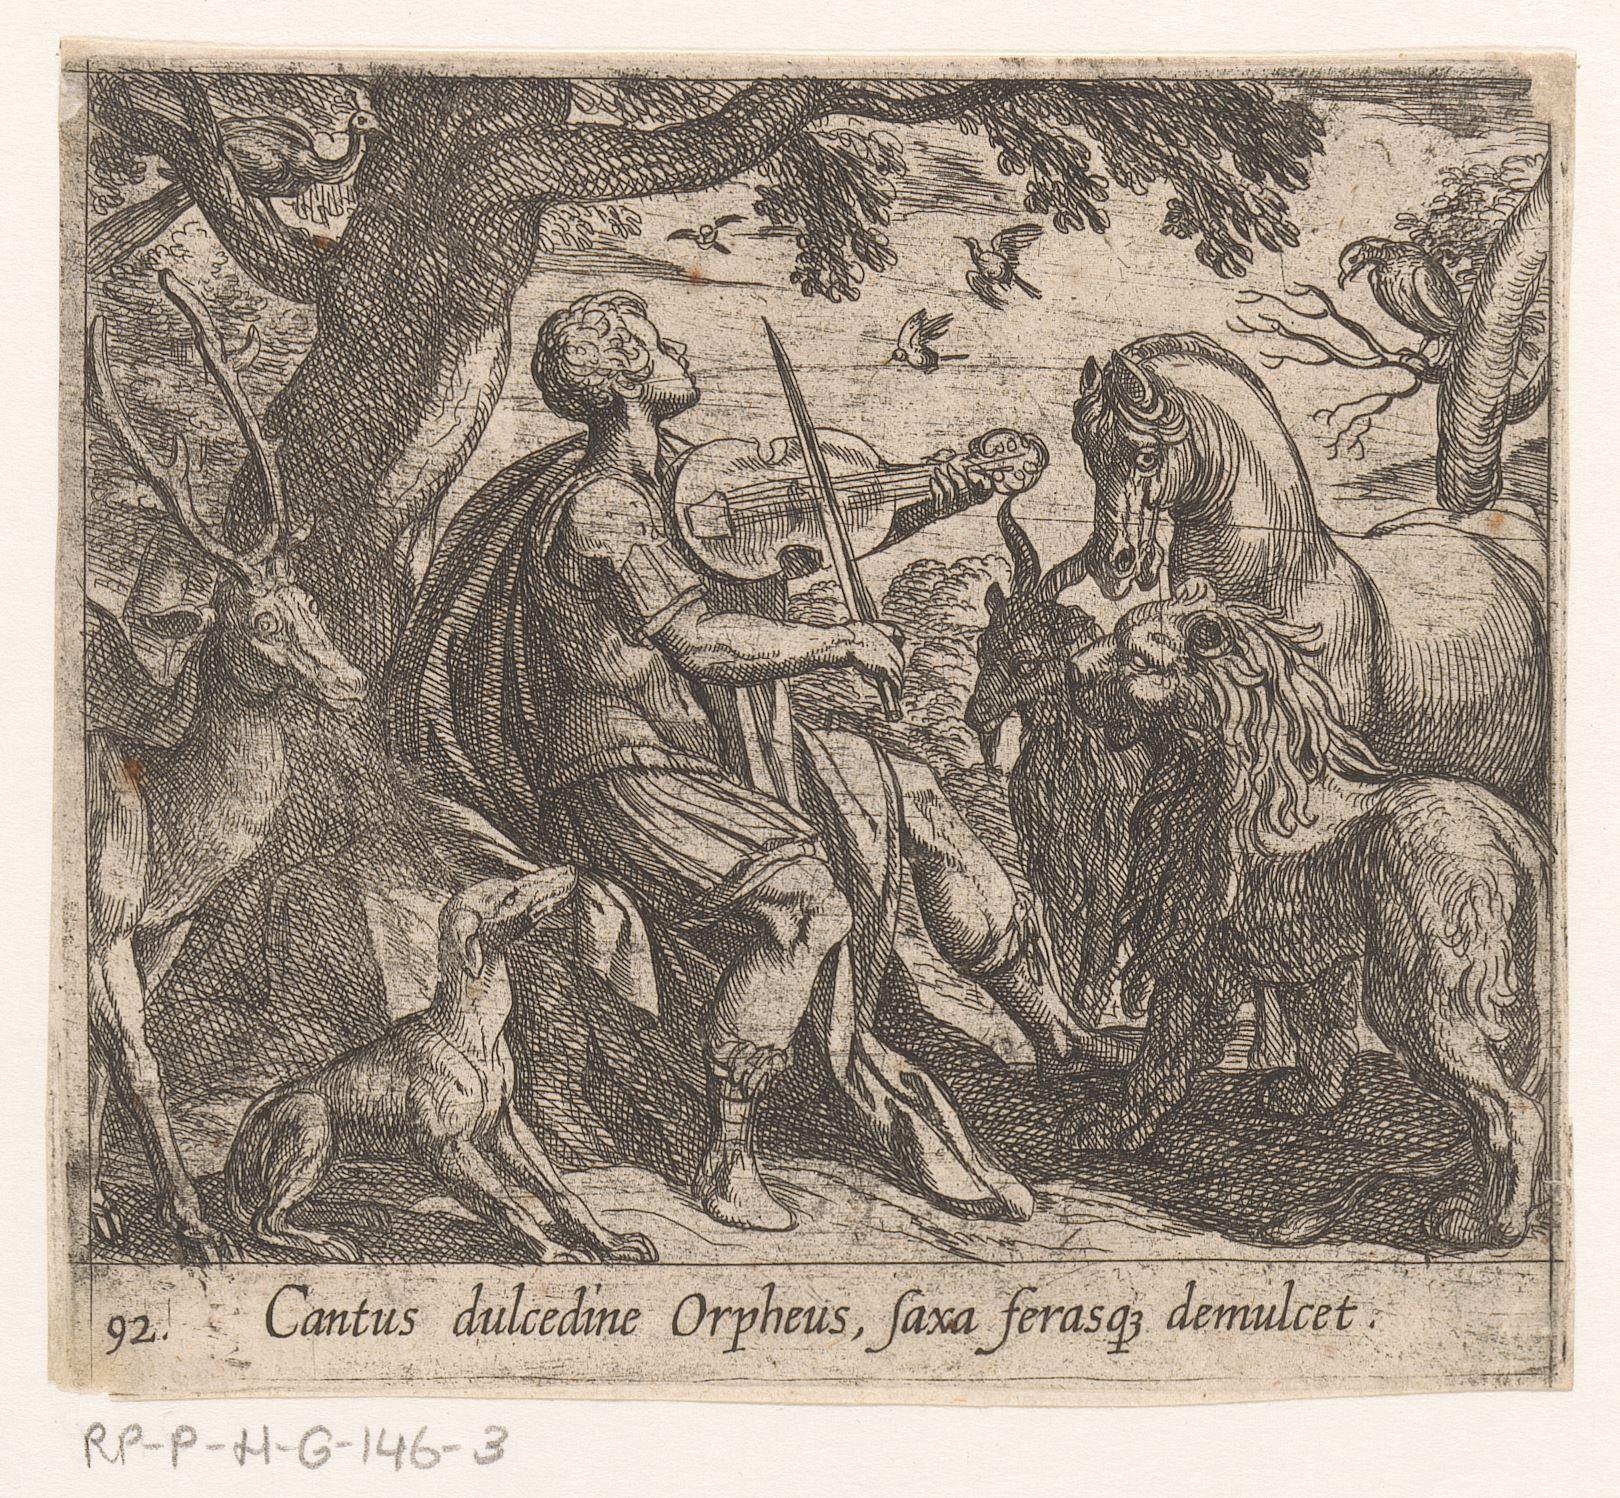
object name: print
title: Metamorfosen van Ovidius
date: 1606-1638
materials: paper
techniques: etching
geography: amsterdam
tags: orpheus playing the lyre: trees and rocks move, beasts and birds are enchanted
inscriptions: collector's mark: ‘Hinloopen’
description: Orpheus zit onder een grote boom en bespeelt een viola da bracchia. Hij betovert de dieren met zijn muziek. Rondom Orpheus staan verschillende dieren, zoals een paard, een leeuw en een hond. Titel in het Latijn in ondermarge.